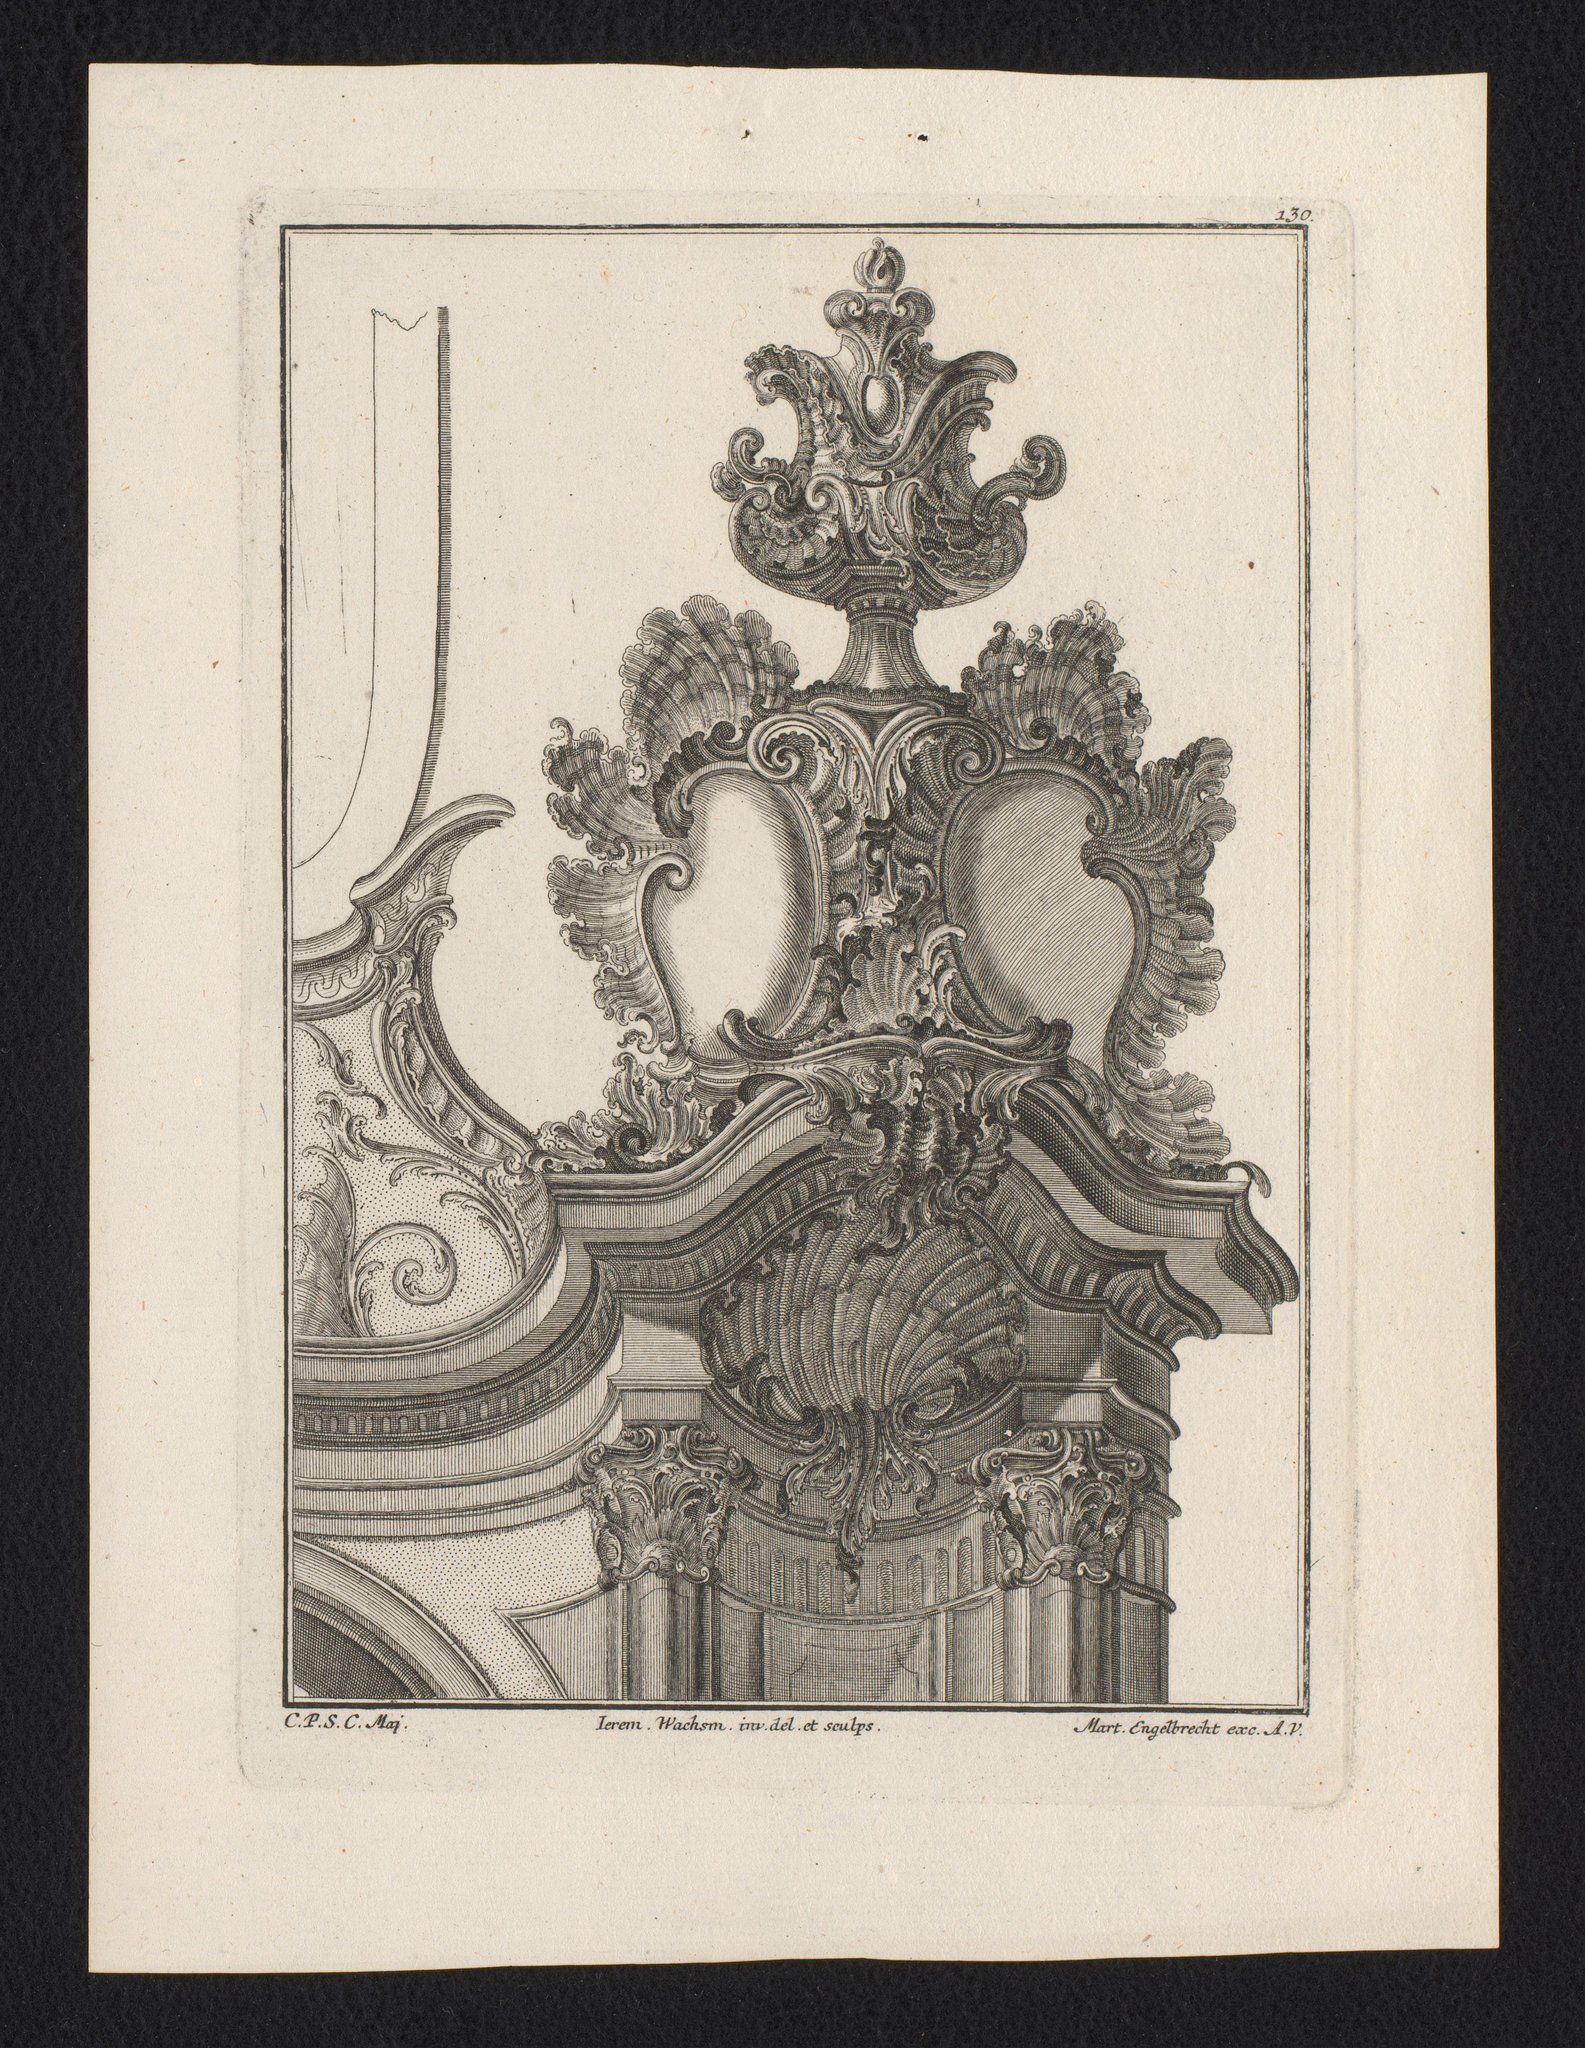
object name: print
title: Allerneueste Façon von Aussierungen zu Portalen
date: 1721-1756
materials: paper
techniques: etching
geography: augsburg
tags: monumental door, porch, 'aediculum', rocaille ornament, vase ~ ornament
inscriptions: collector's mark: Lugt 2166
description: Detail van een portaaldecoratie met rocaille ornamenten en rechts een vaas. Prentnummer 130.